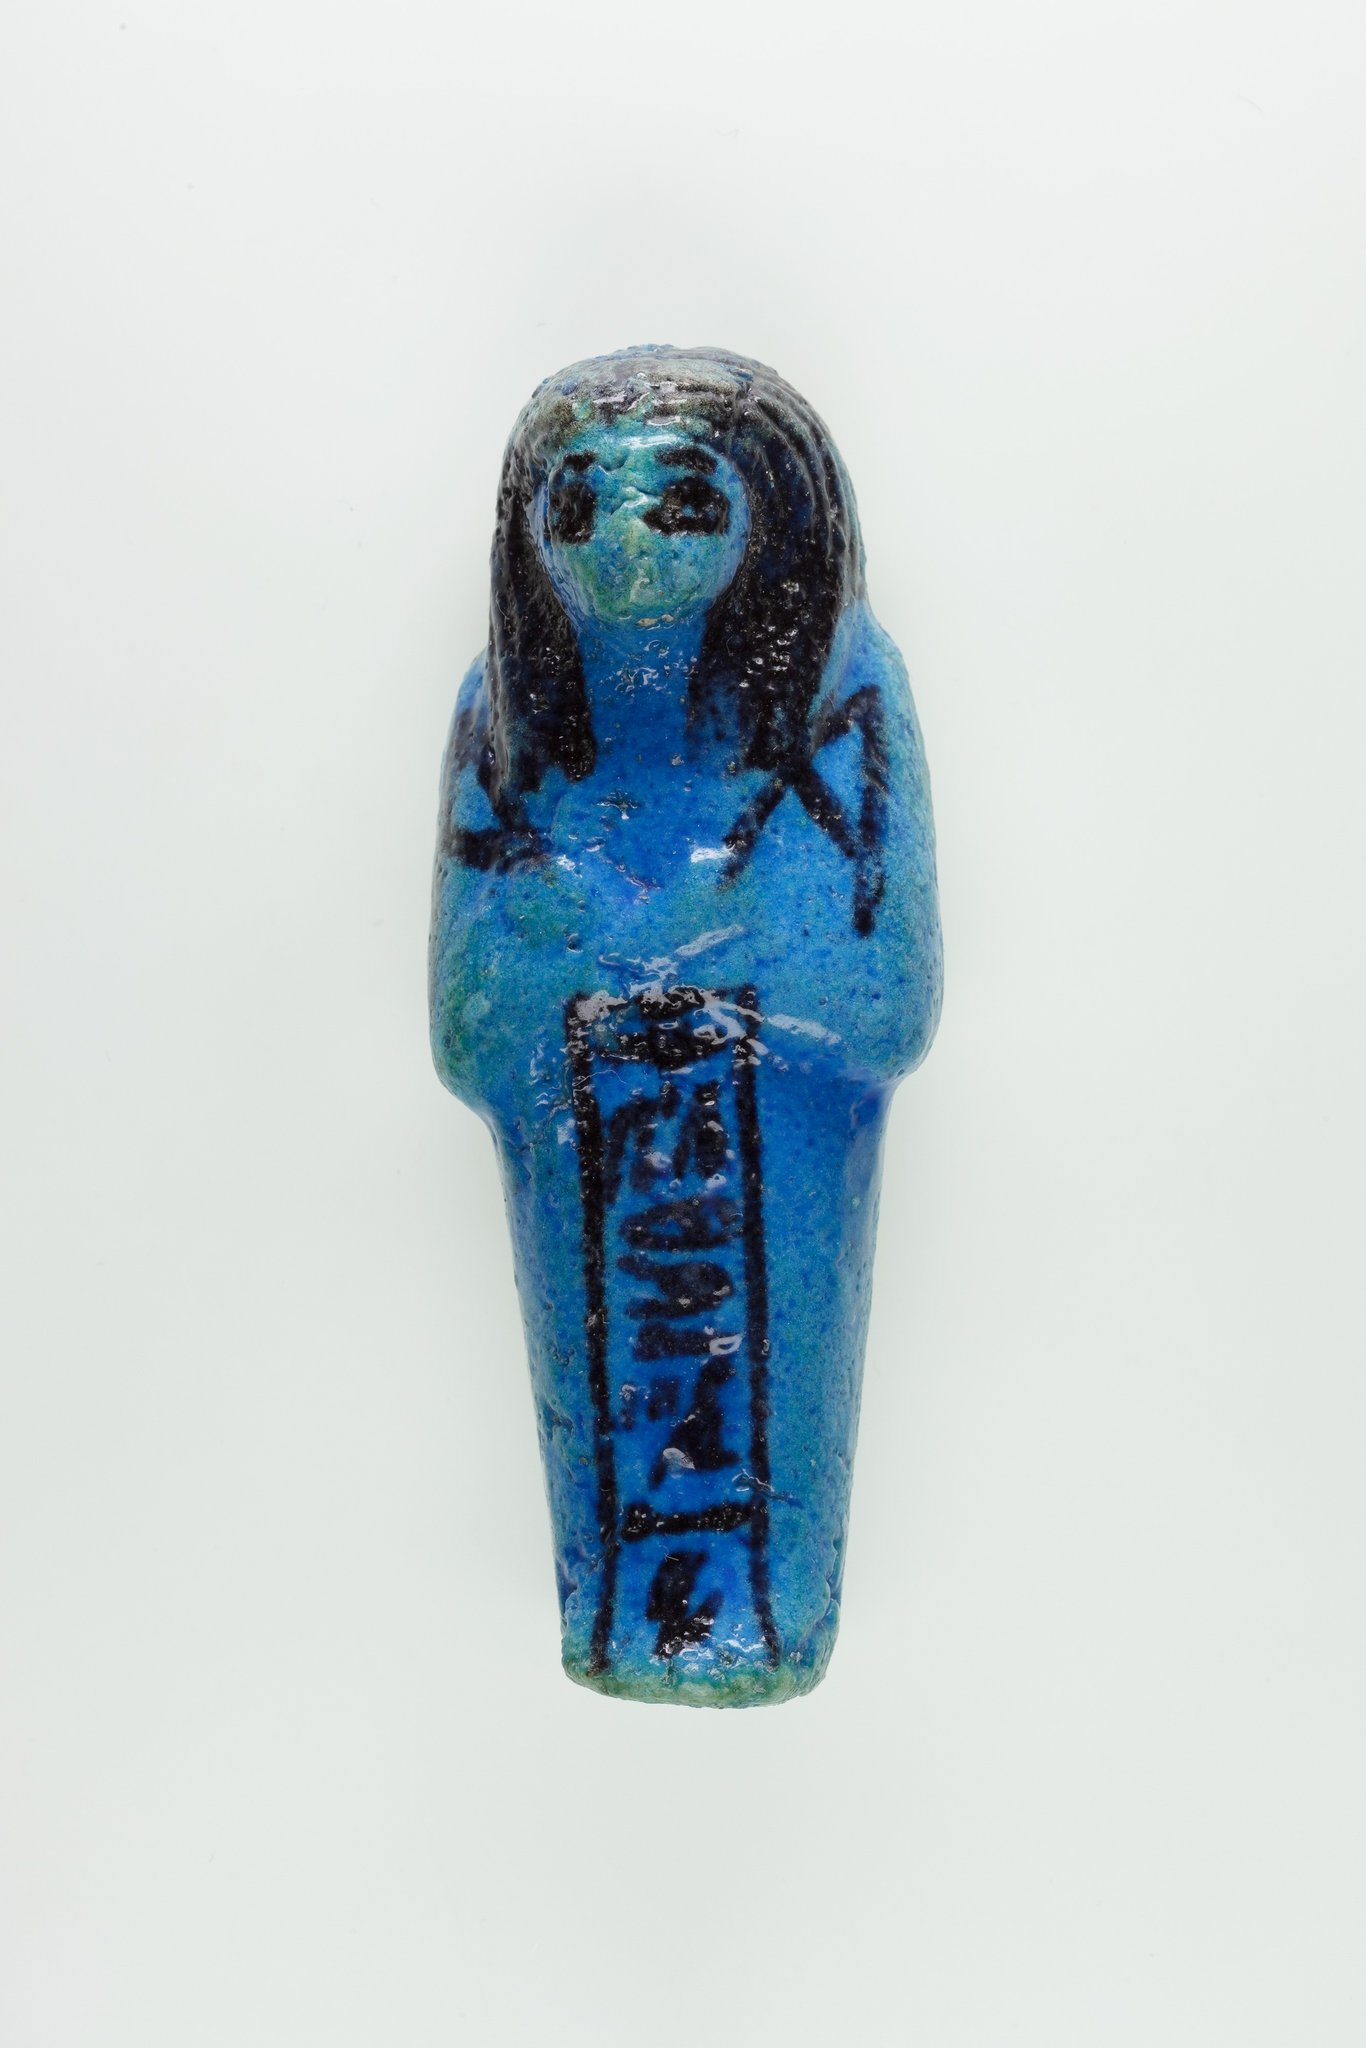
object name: shabti, worker, nauny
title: Worker Shabti of Nauny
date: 1050 BCE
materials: faience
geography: egypt